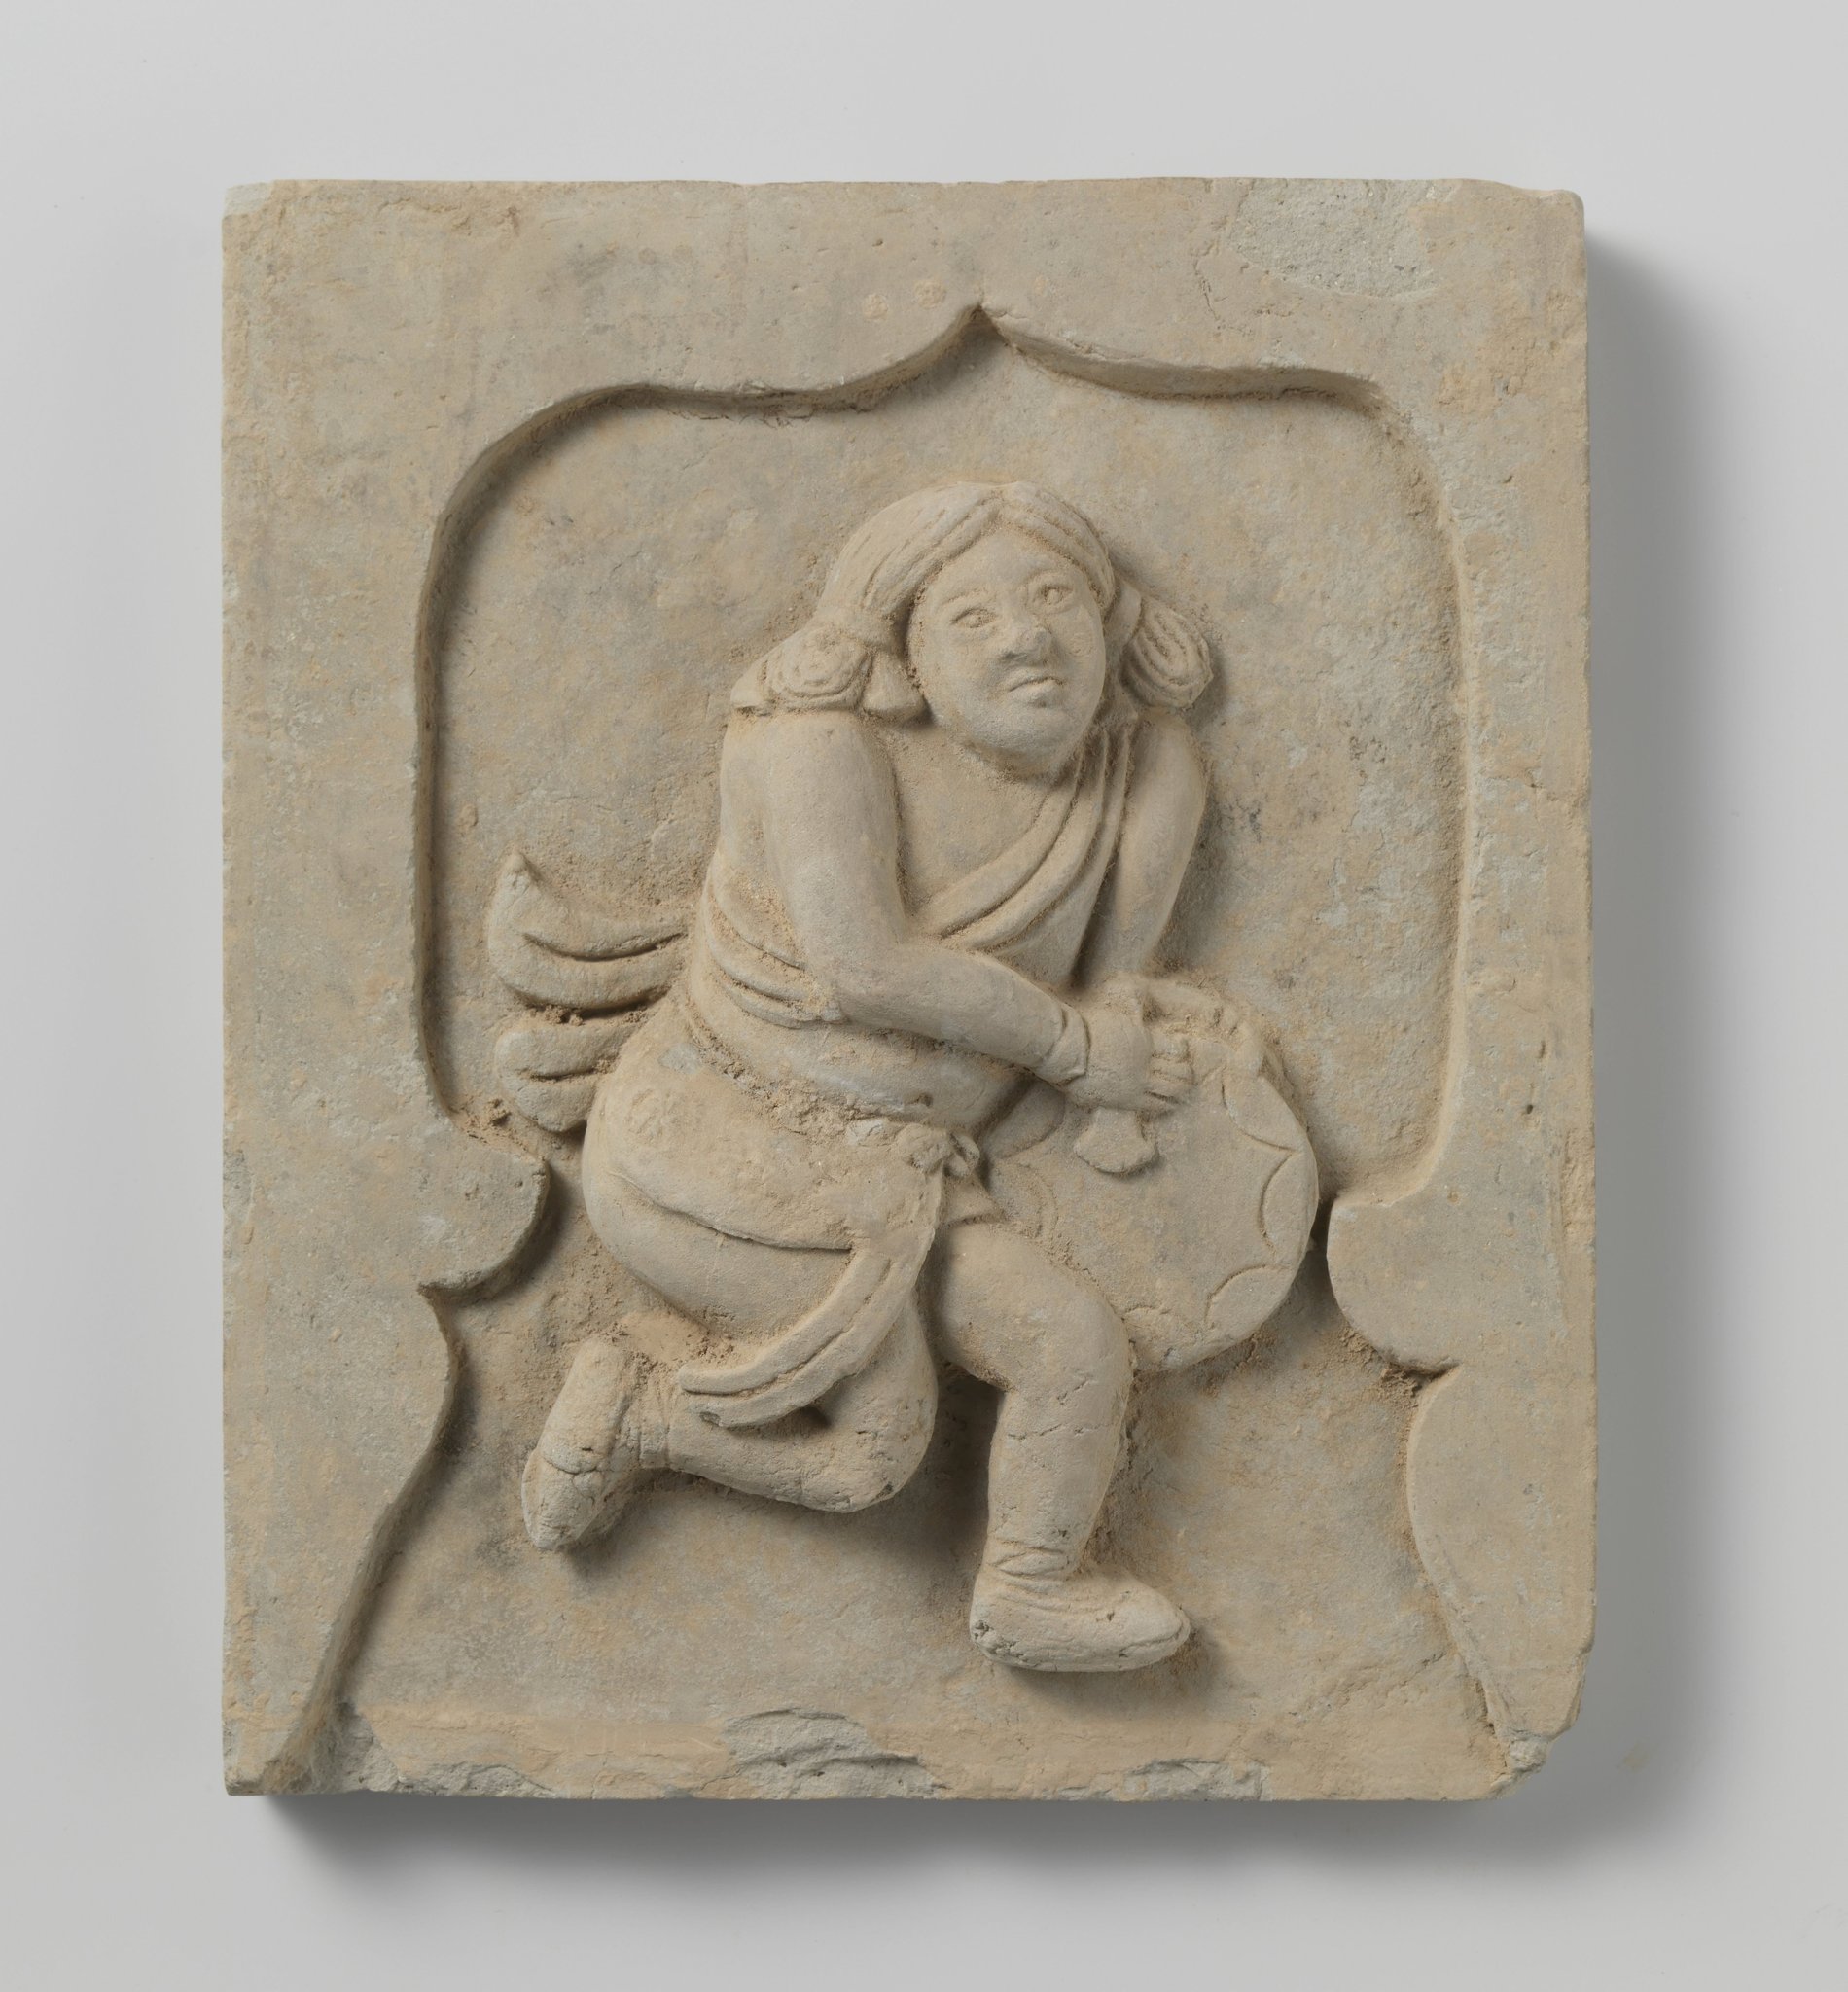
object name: tile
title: Tegel met een voorstelling van een tromspeler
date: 1100-1400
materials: stoneware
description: Dancing man with castanets. Dancing drummer. Tomb tiles. China. Yuan period (1260 - 1368), mid-13th century. Earthenware. Between c. 1100 and 1400, graves were embellished with series of these musician tiles. The tiles were produced in moulds allowing large numbers of the same kind to be made. A second example of the dancing man with castanets has been found.